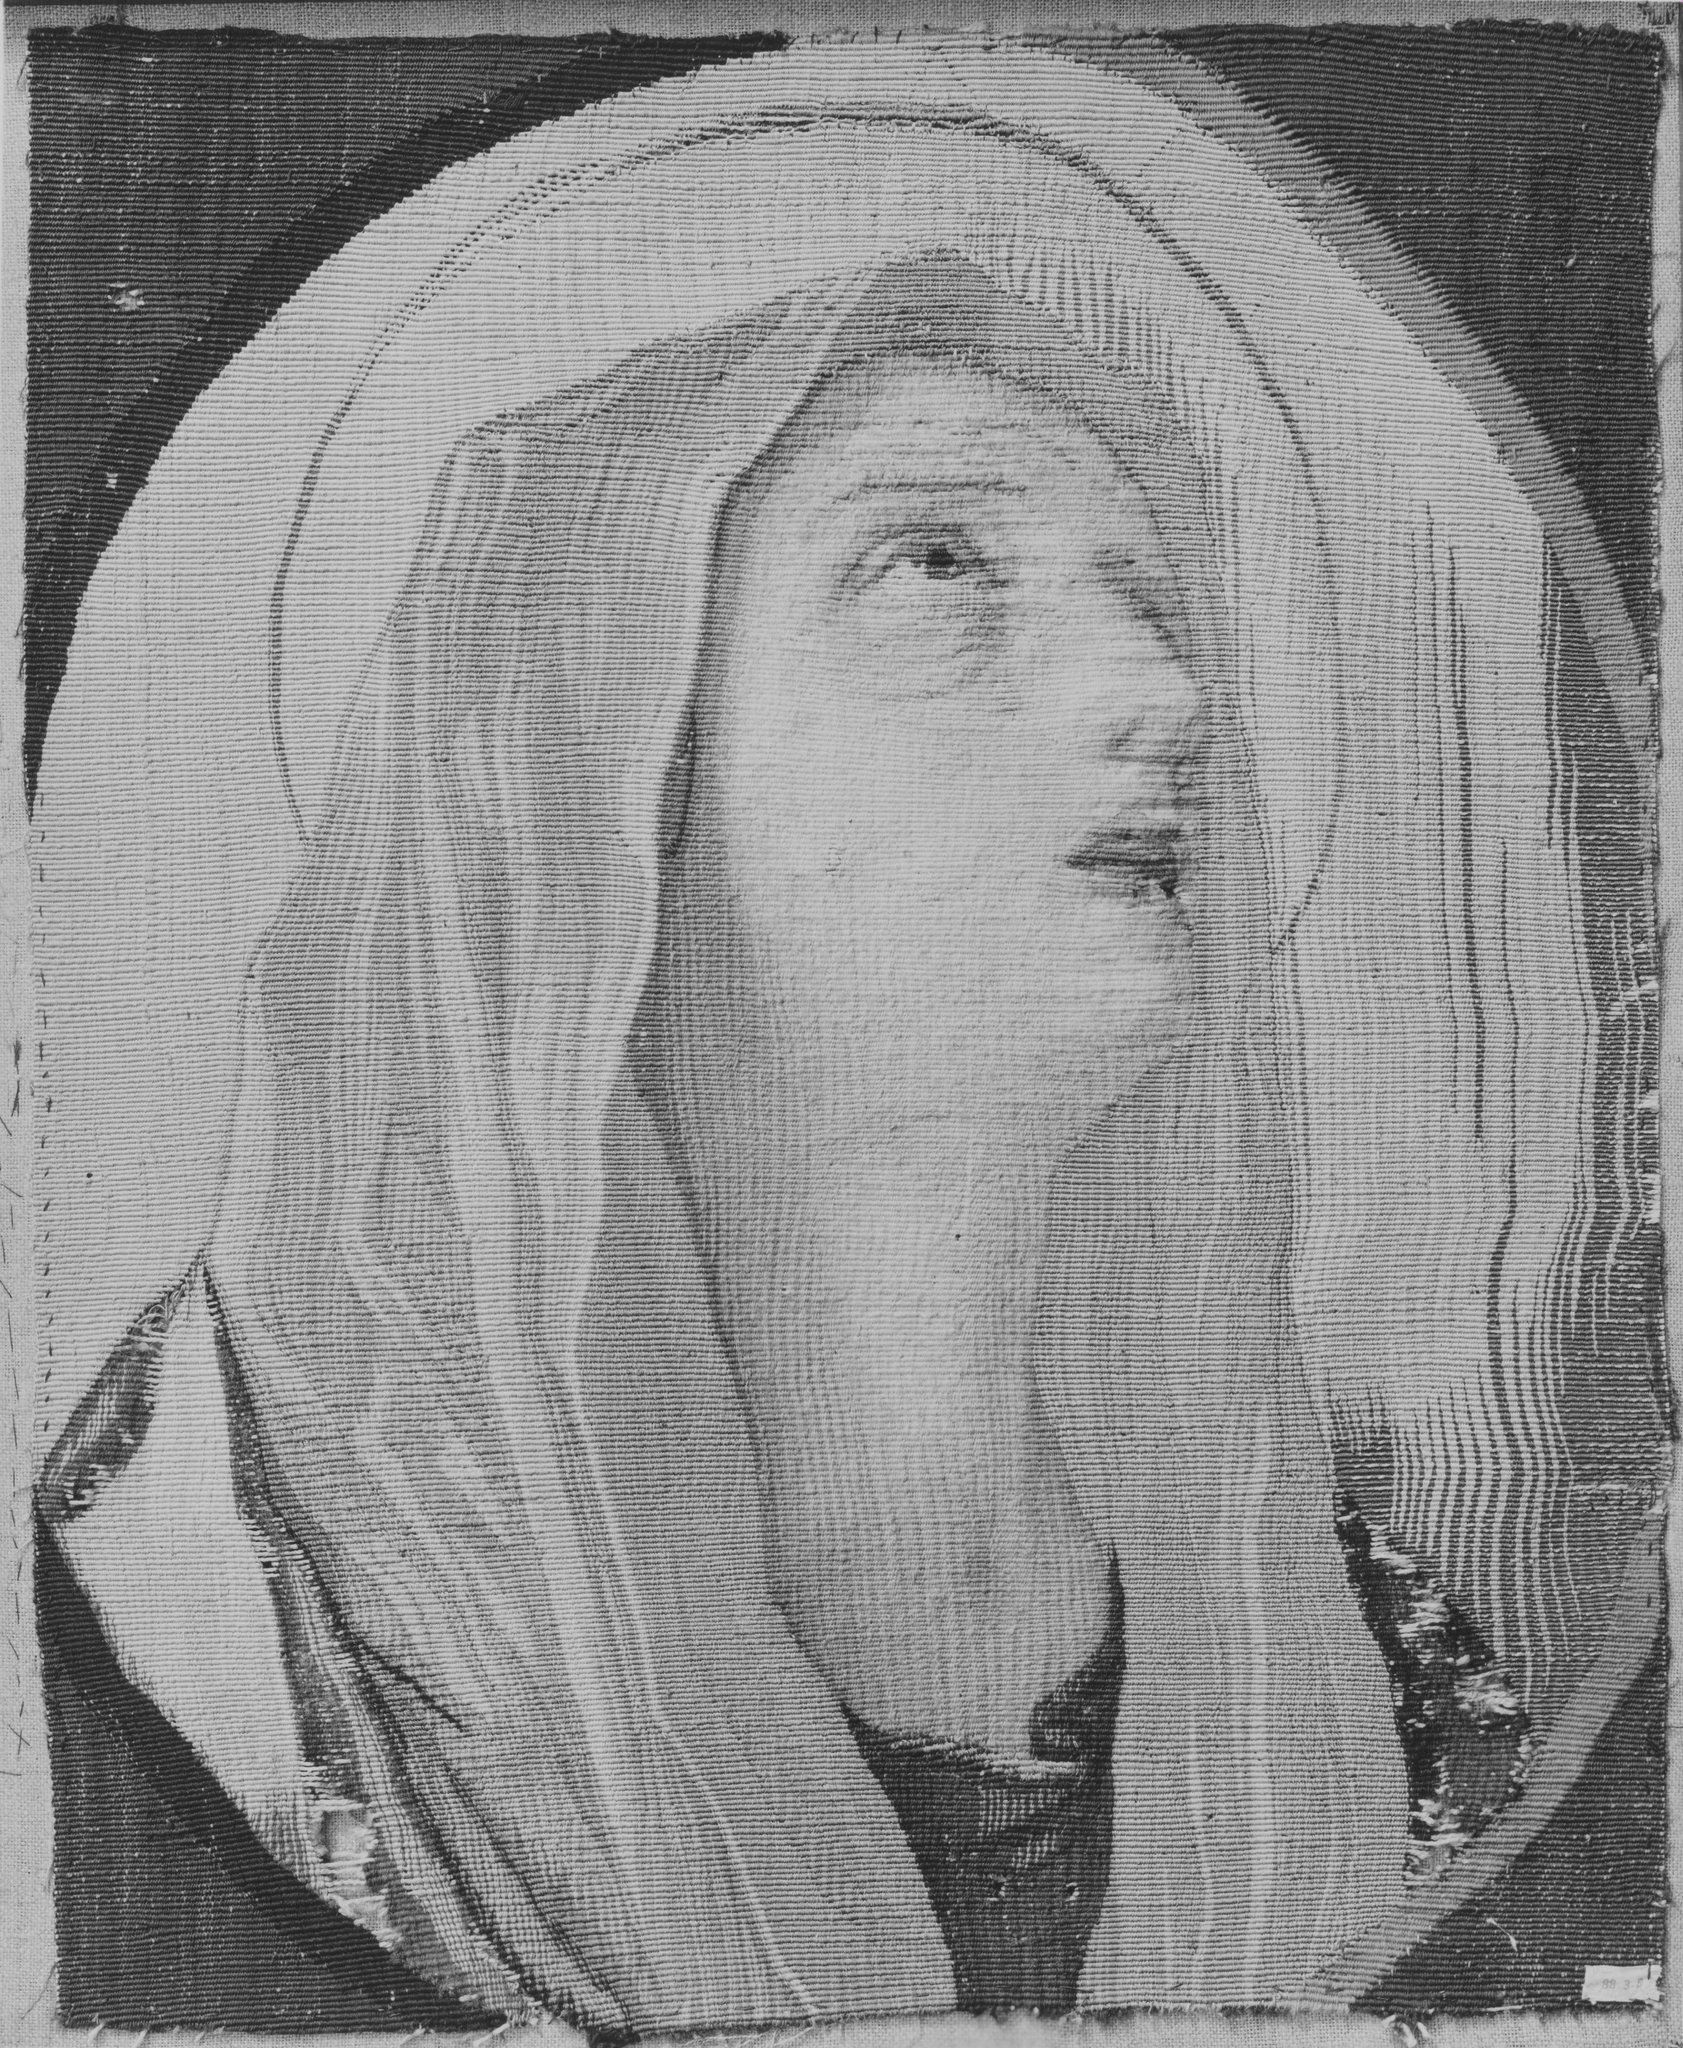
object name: tapestry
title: Head of the Virgin (Mater Dolorosa)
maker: pietro ferloni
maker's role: artist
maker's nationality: italian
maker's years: 1717-1770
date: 1734-1766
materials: silk, wool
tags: heads,profiles,virgin mary